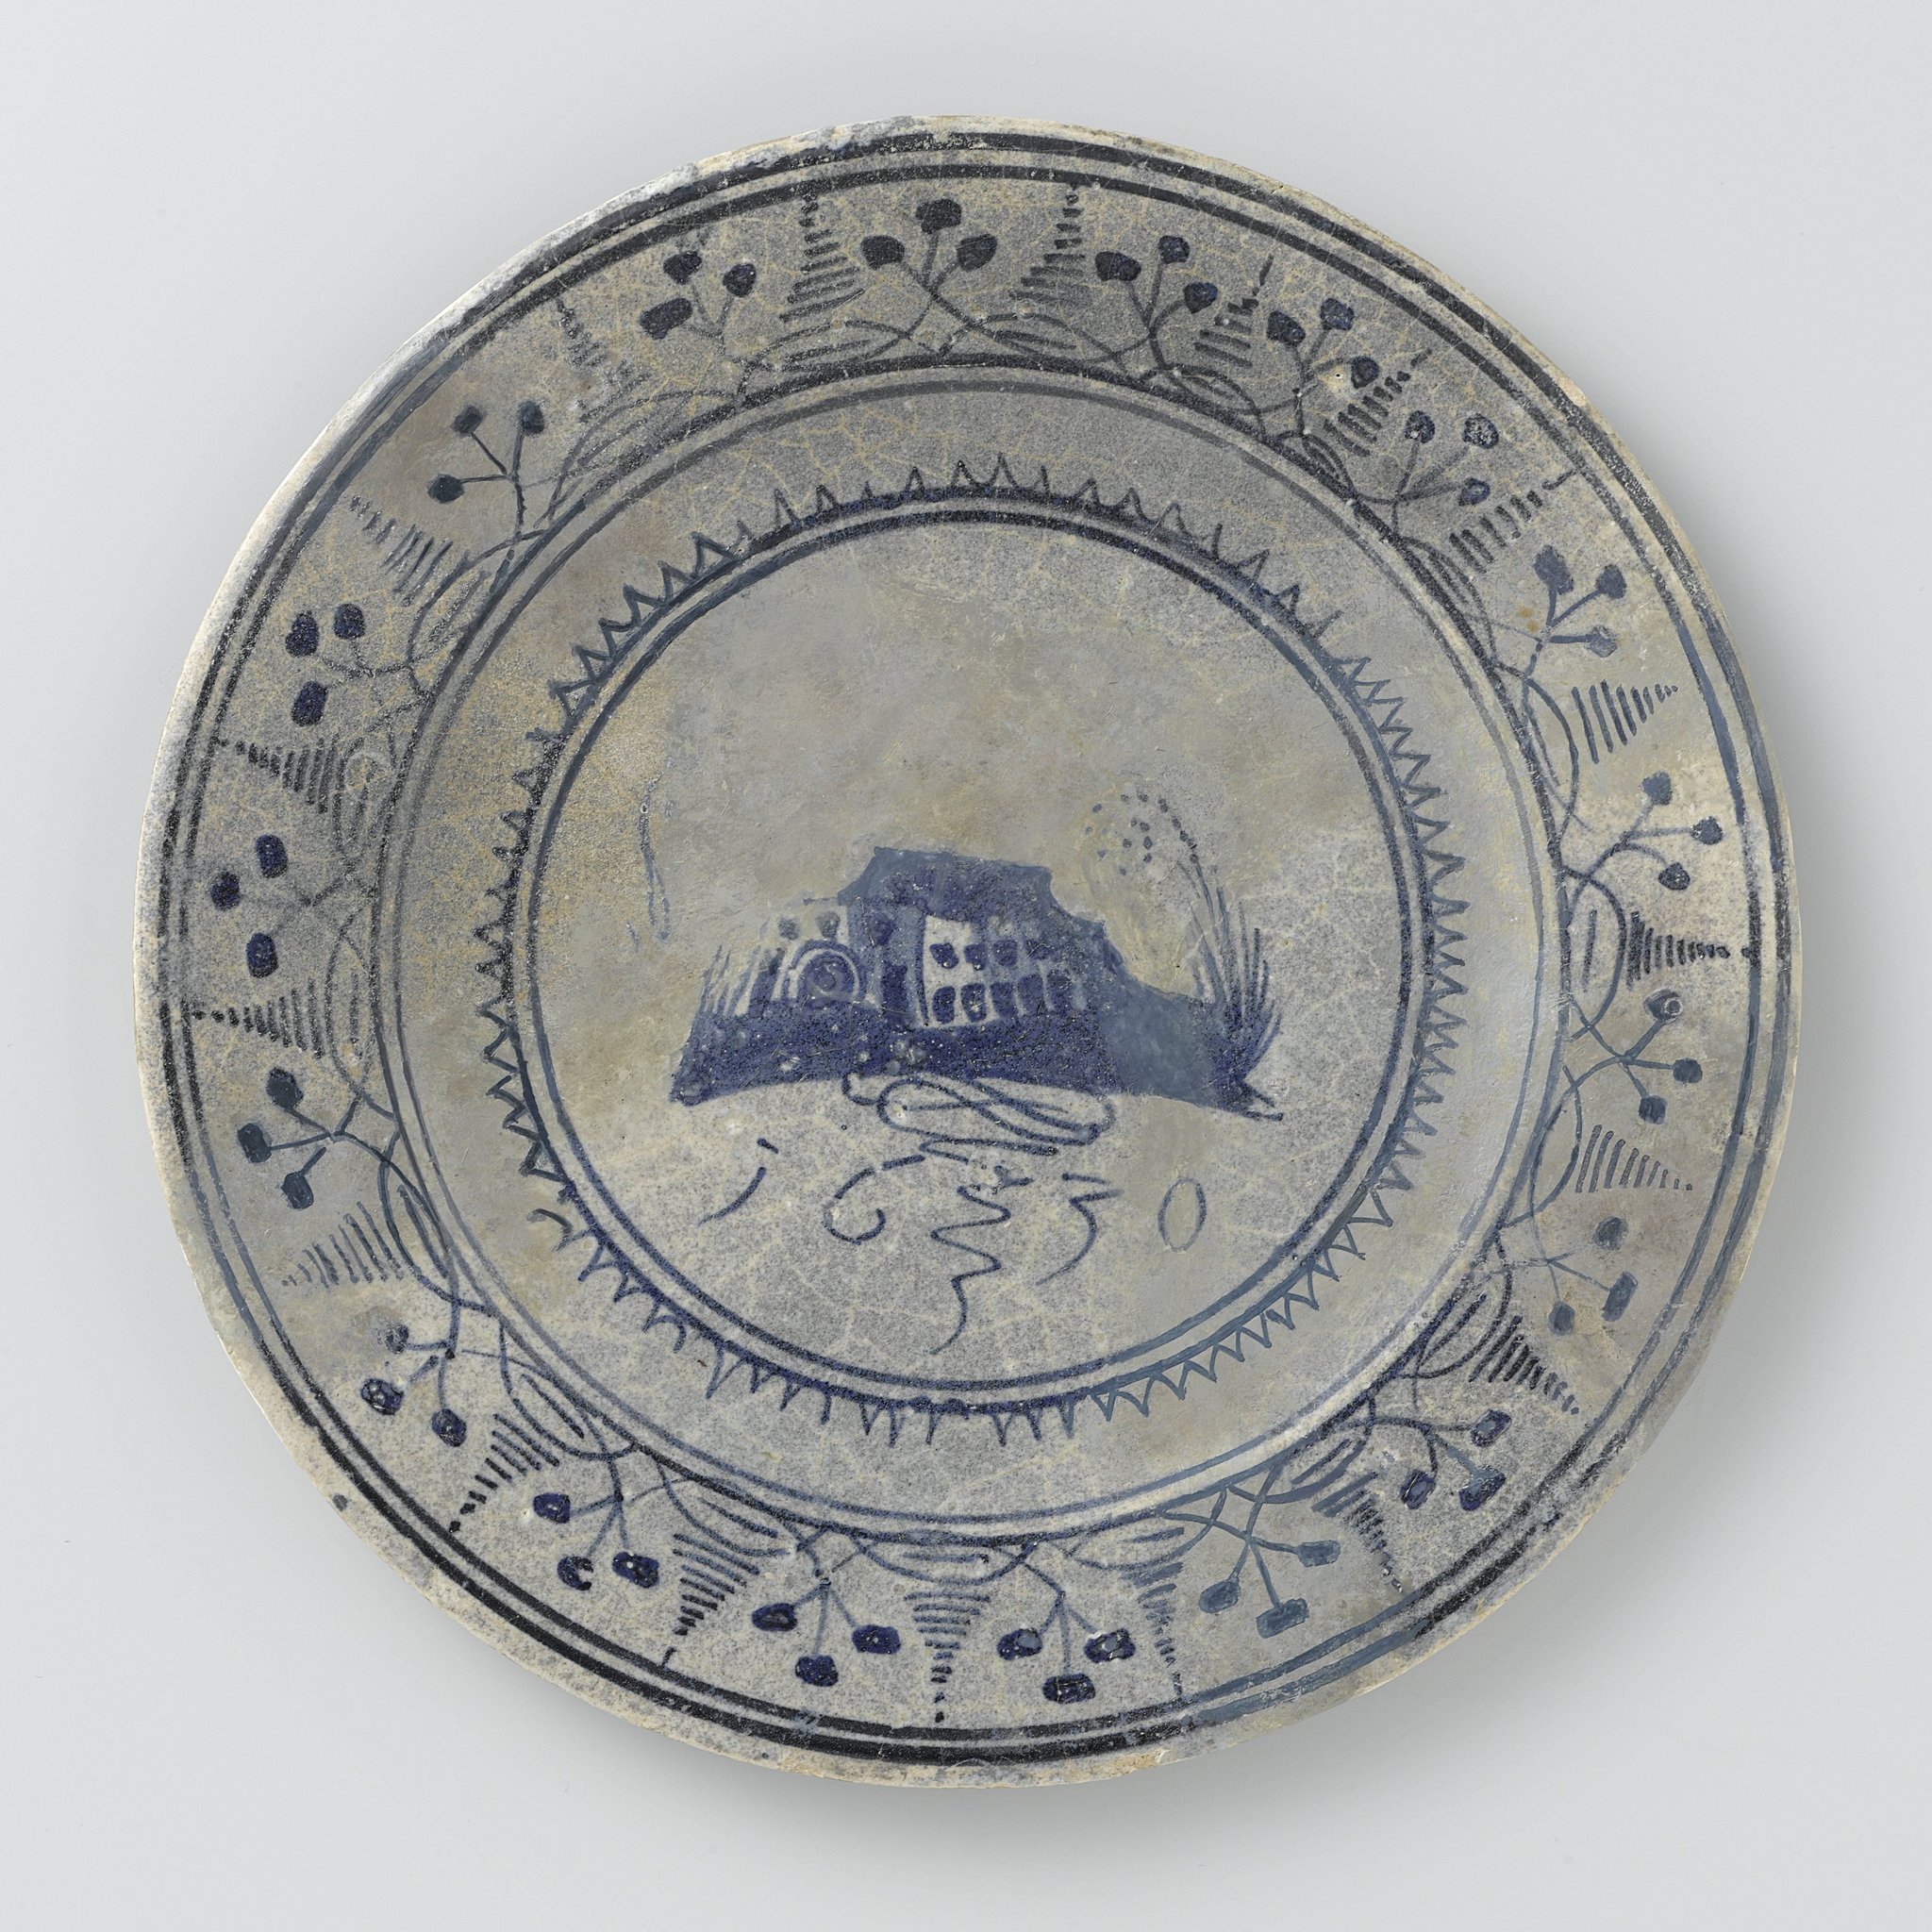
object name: plate dish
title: Bord, beschilderd met een huis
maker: Anonymous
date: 1630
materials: earthenware, glaze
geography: delft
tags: civic architecture; edifices; dwellings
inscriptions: date: ‘1630’, date: ‘ANNO 1630’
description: Bord van faience, beschilderd in blauw met een huis. Gedateerd: 1630. Het bord is een bodemvondst.